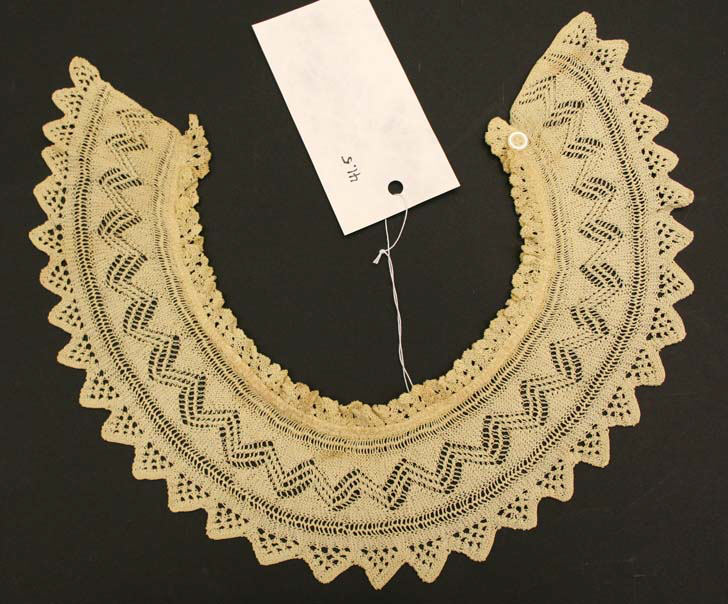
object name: collar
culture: american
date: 1878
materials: cotton